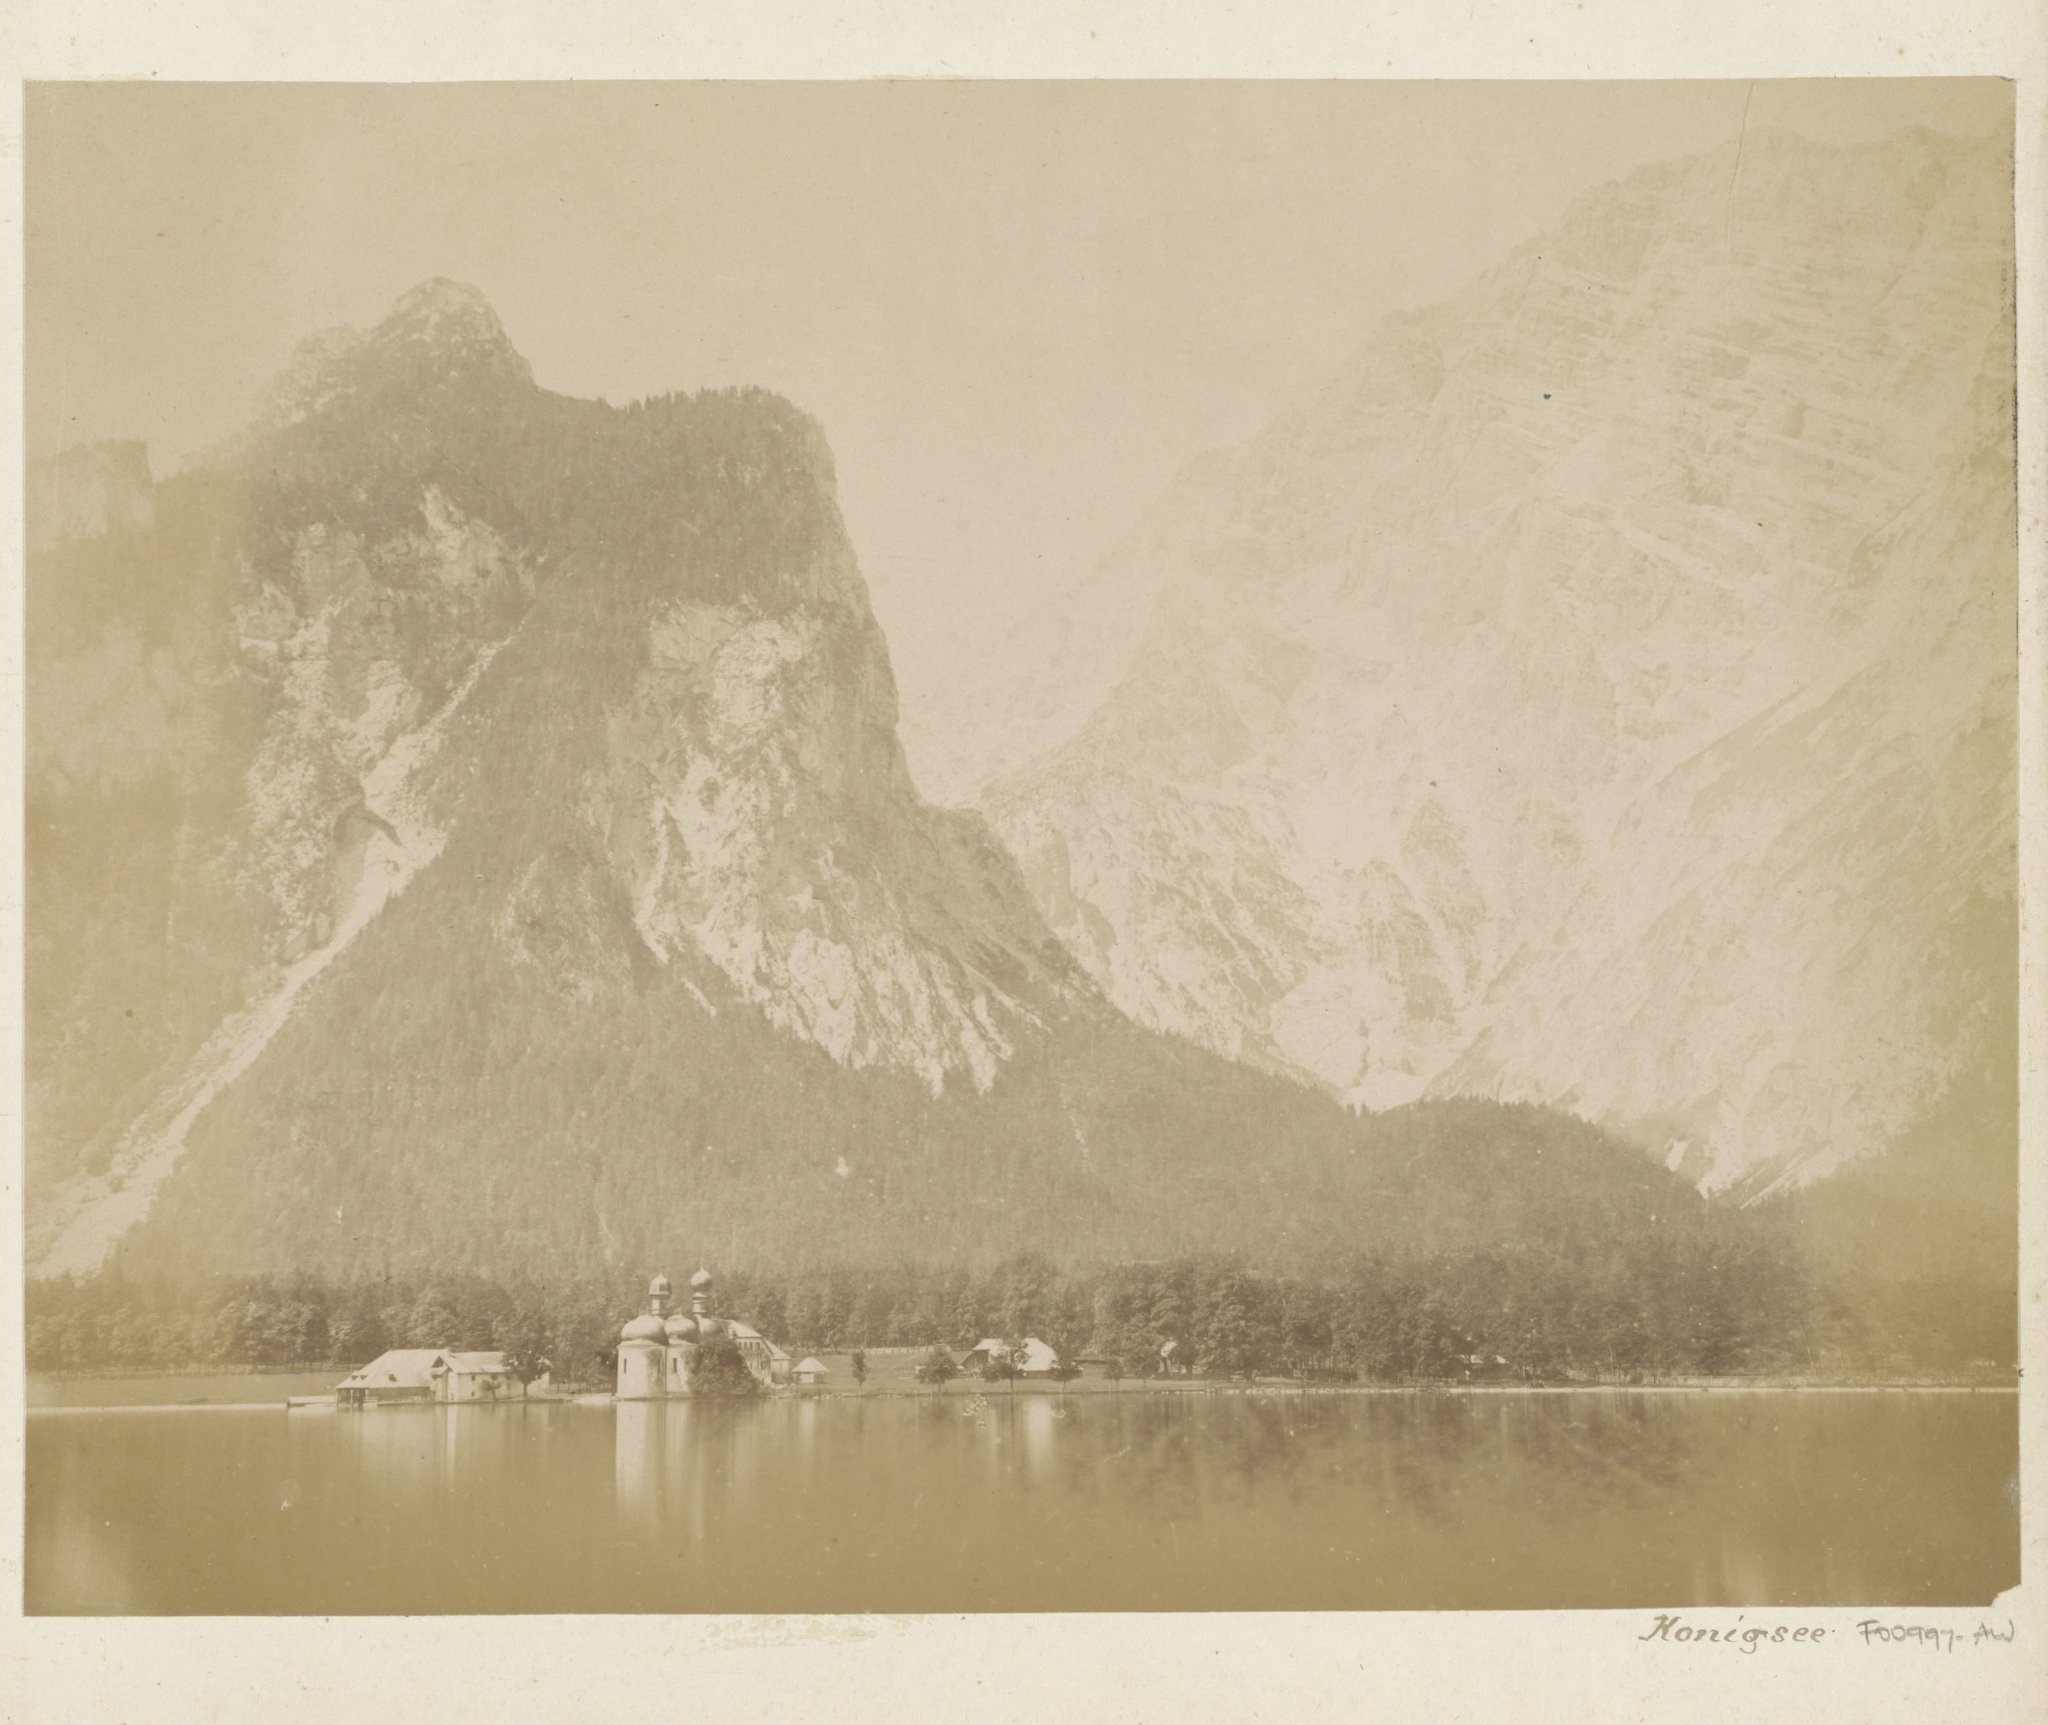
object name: photograph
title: Gezicht op de Königssee, de Sint-Bartholomeüskerk en de achterliggende bergen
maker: Anonymous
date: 1860-1890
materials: paper, photographic support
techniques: albumen print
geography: königssee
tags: lake, mountain-range, snow peaks, church (exterior) - qq - small church, chapel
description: Onderdeel van Reisalbum met foto's van Zwitserland, Oostenrijk, Italië en Duitsland.